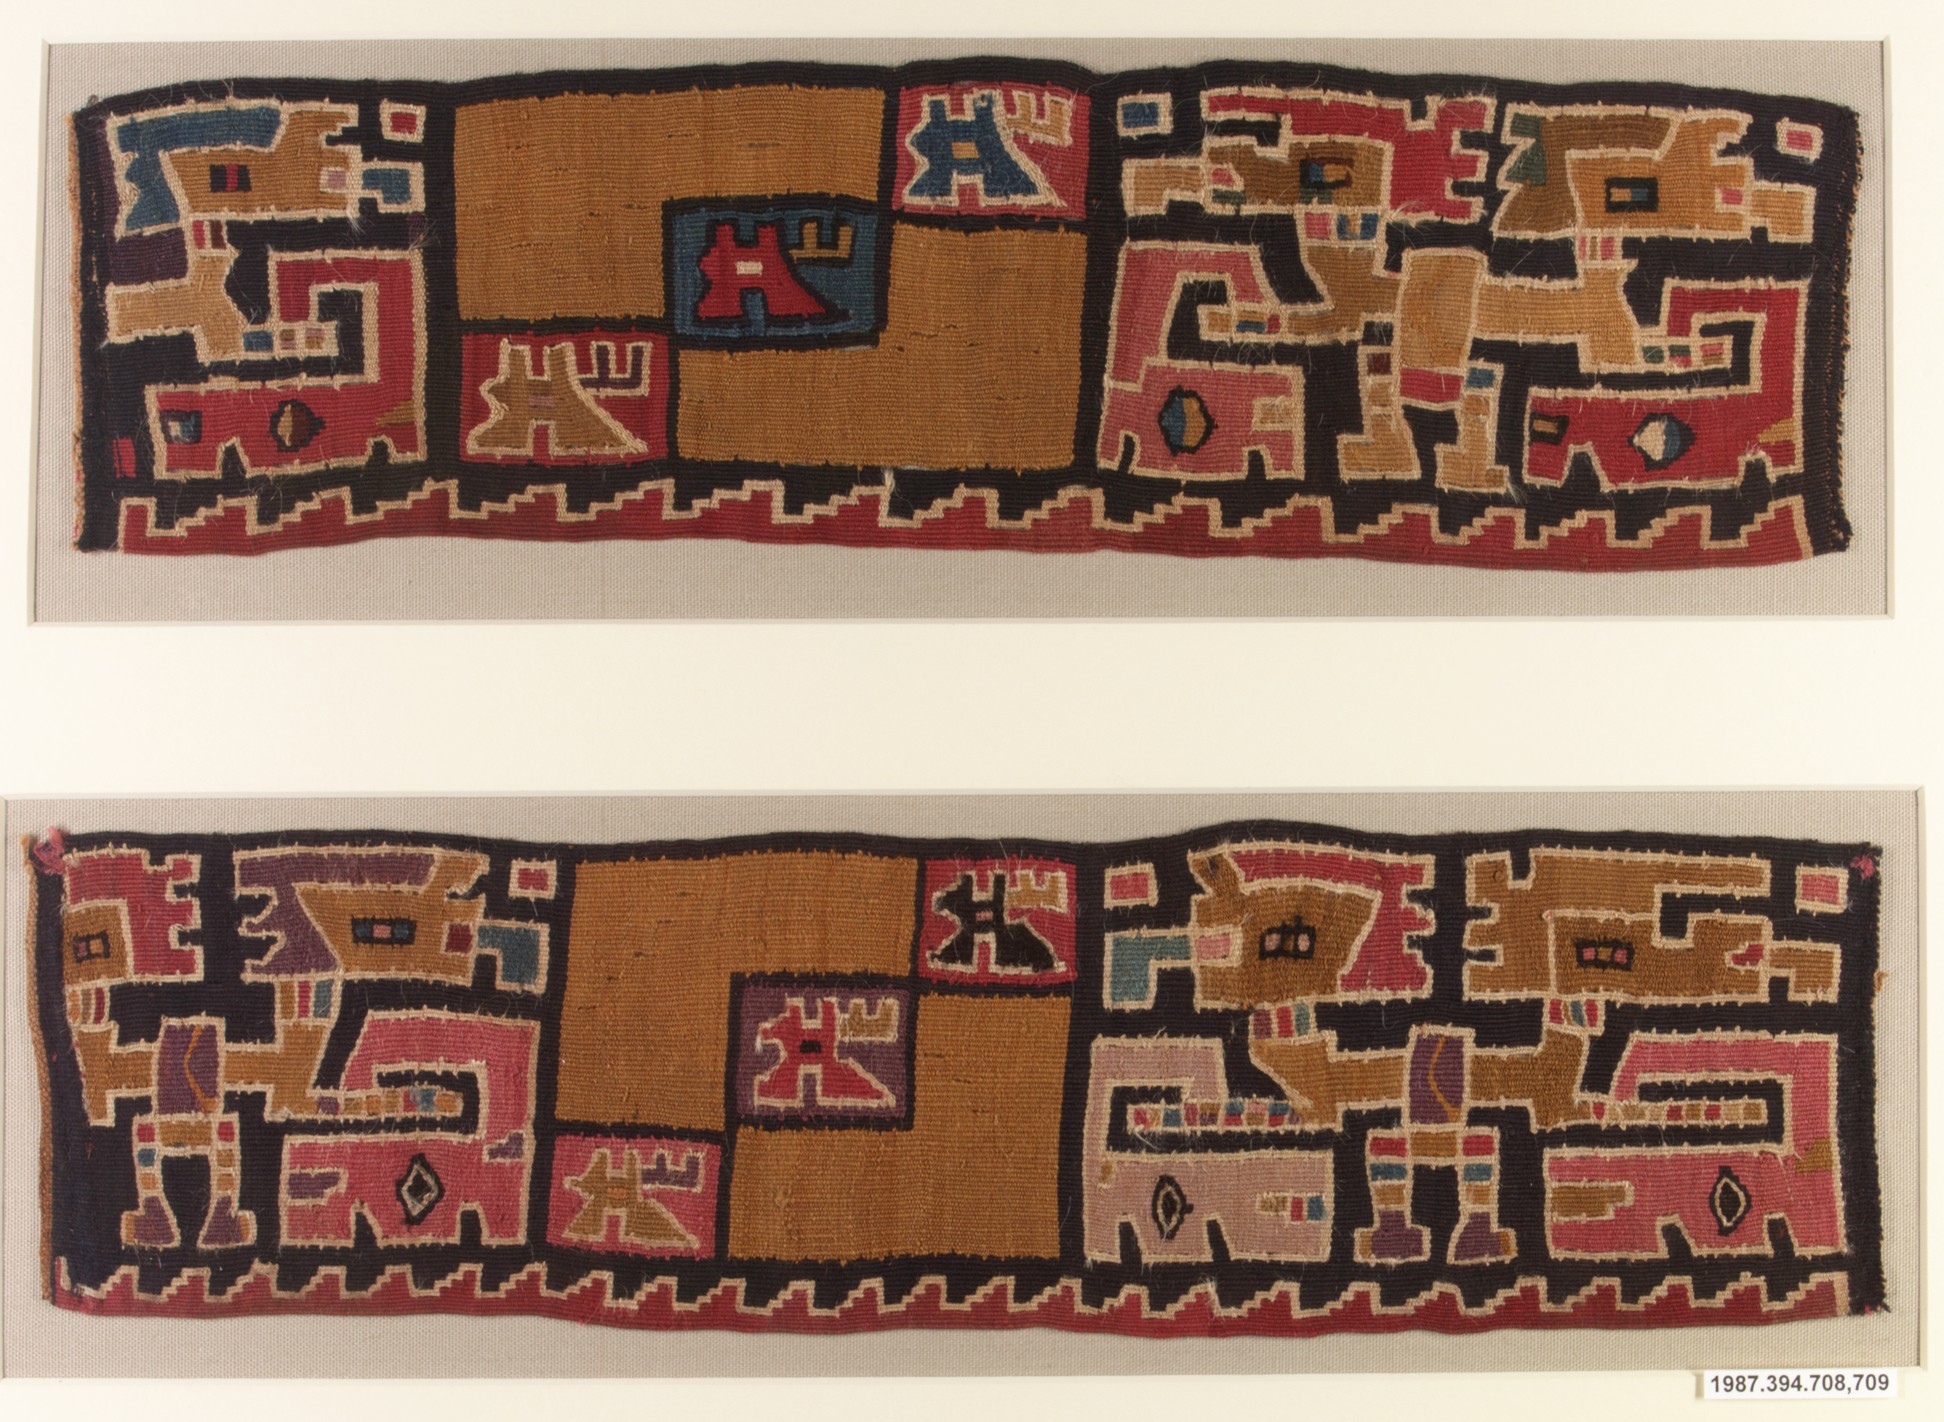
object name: cuff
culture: moche or wari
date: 601-800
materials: animal fiber, cotton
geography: peru